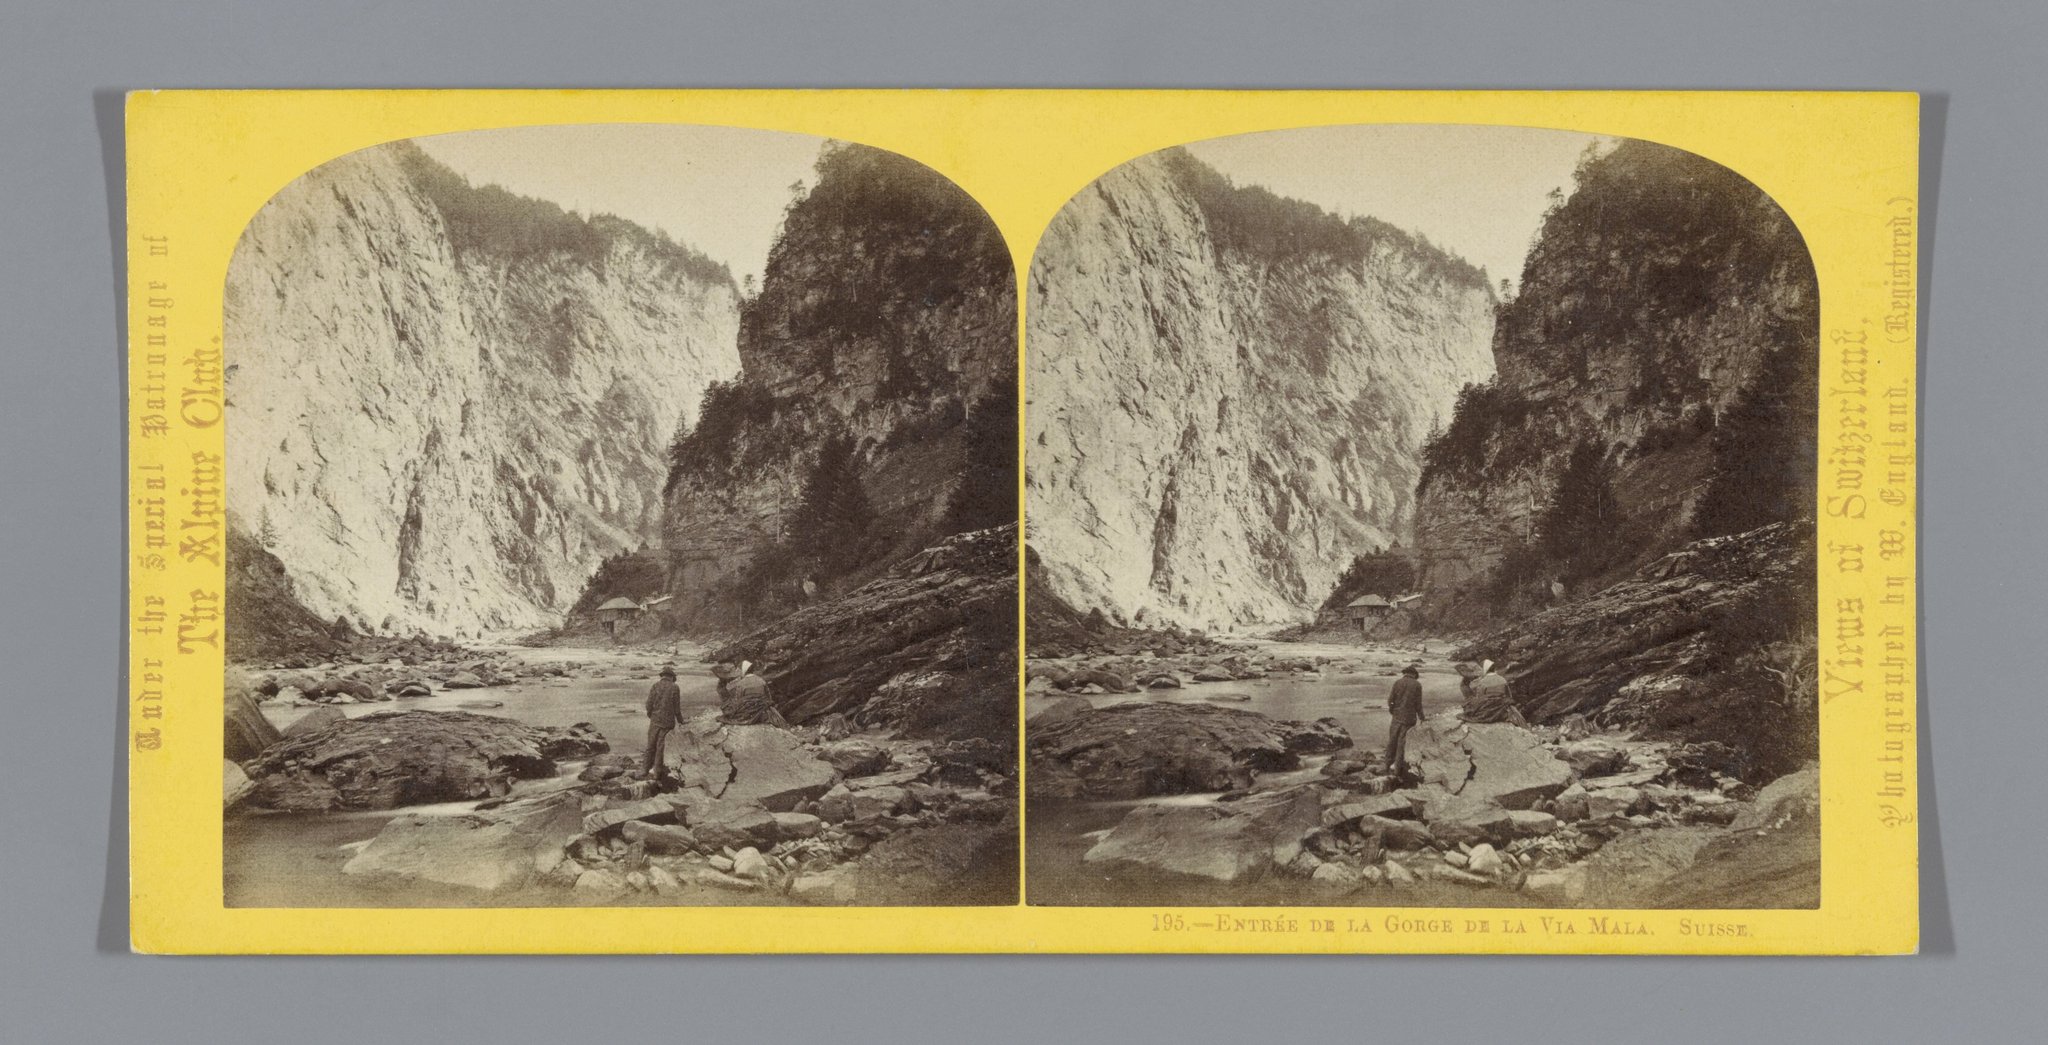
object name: stereograph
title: Kloof op de Via Mala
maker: william england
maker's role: fotograaf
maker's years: 1816-1896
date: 1850-1880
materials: cardboard, photographic support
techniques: albumen print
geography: graubunden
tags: ravine, chasm, abyss, canyon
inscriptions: number: ‘195.’, inscription: ‘Views of Switzerland, photographed by W. England. (Registered) Under the Special Patronage of the Alpine Club.’